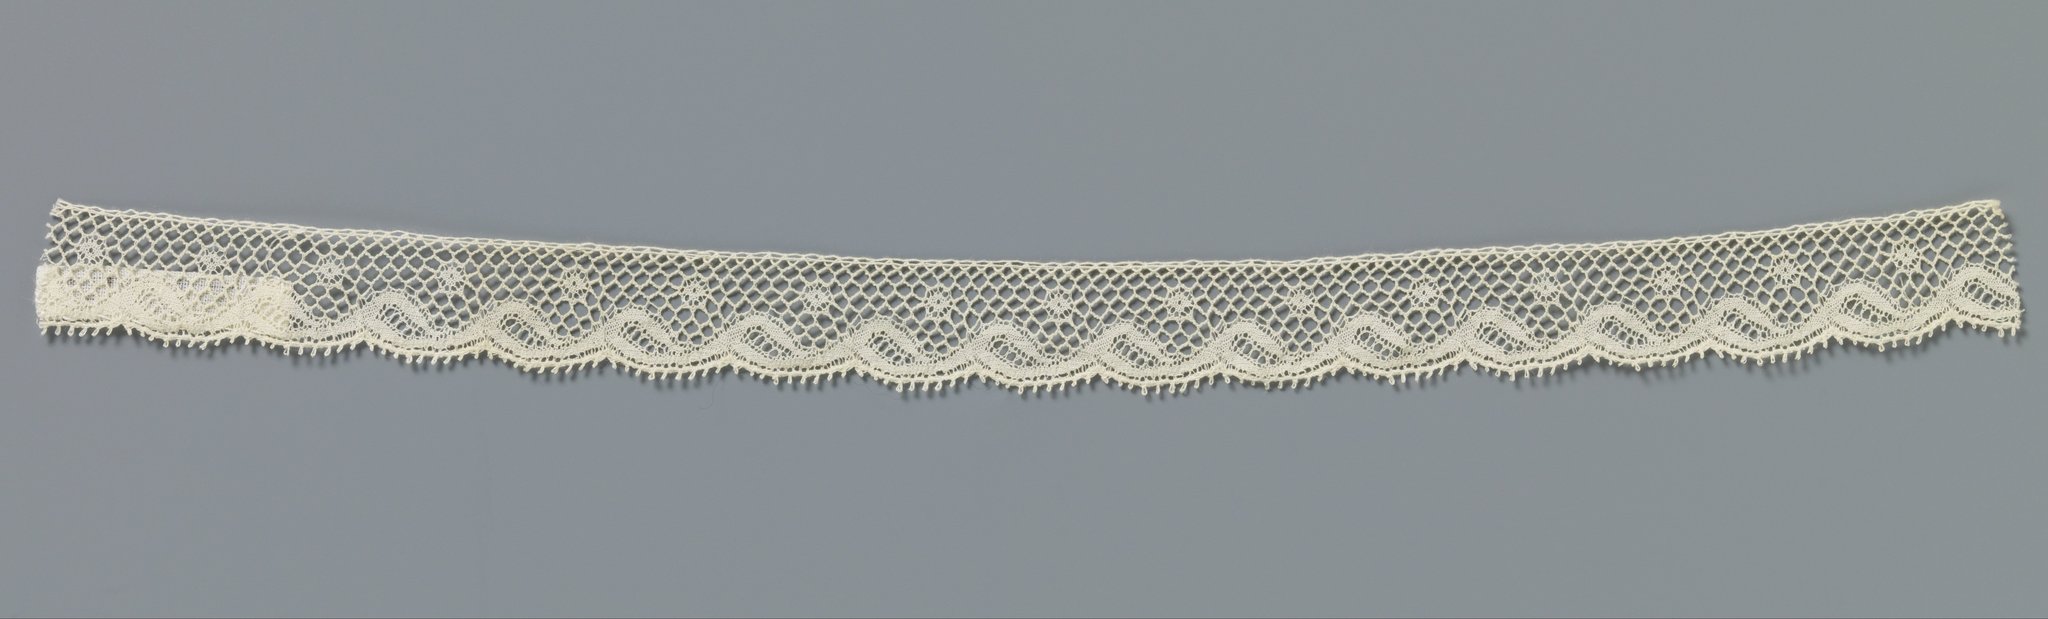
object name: strip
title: Strook machinale kant met een rij sneeuwvlokken boven een golvende schulpenrand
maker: Anonymous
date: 1900-1924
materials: cotton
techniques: lace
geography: europe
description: Strook naturelkleurige machinale kant: machinale Valenciennes-kant. Het zich herhalende patroon bestaat uit een rij sneeuwvlokken boven een golvende schulpenrand. De golvende lijn wordt vanuit de maasgrond gevormd door een smal bandje dat na elk golfdal met een boogje terugslaat. De motieven zijn voorzien van opengewerkte randjes en kleine uitsparingen en zijn met elkaar verbonden door een machinale Valenciennes-grond met vierkante maas. De bovenzijde van de strook is recht afgewerkt. De flauwe schulpenrand langs de onderzijde is afgewerkt met picots.